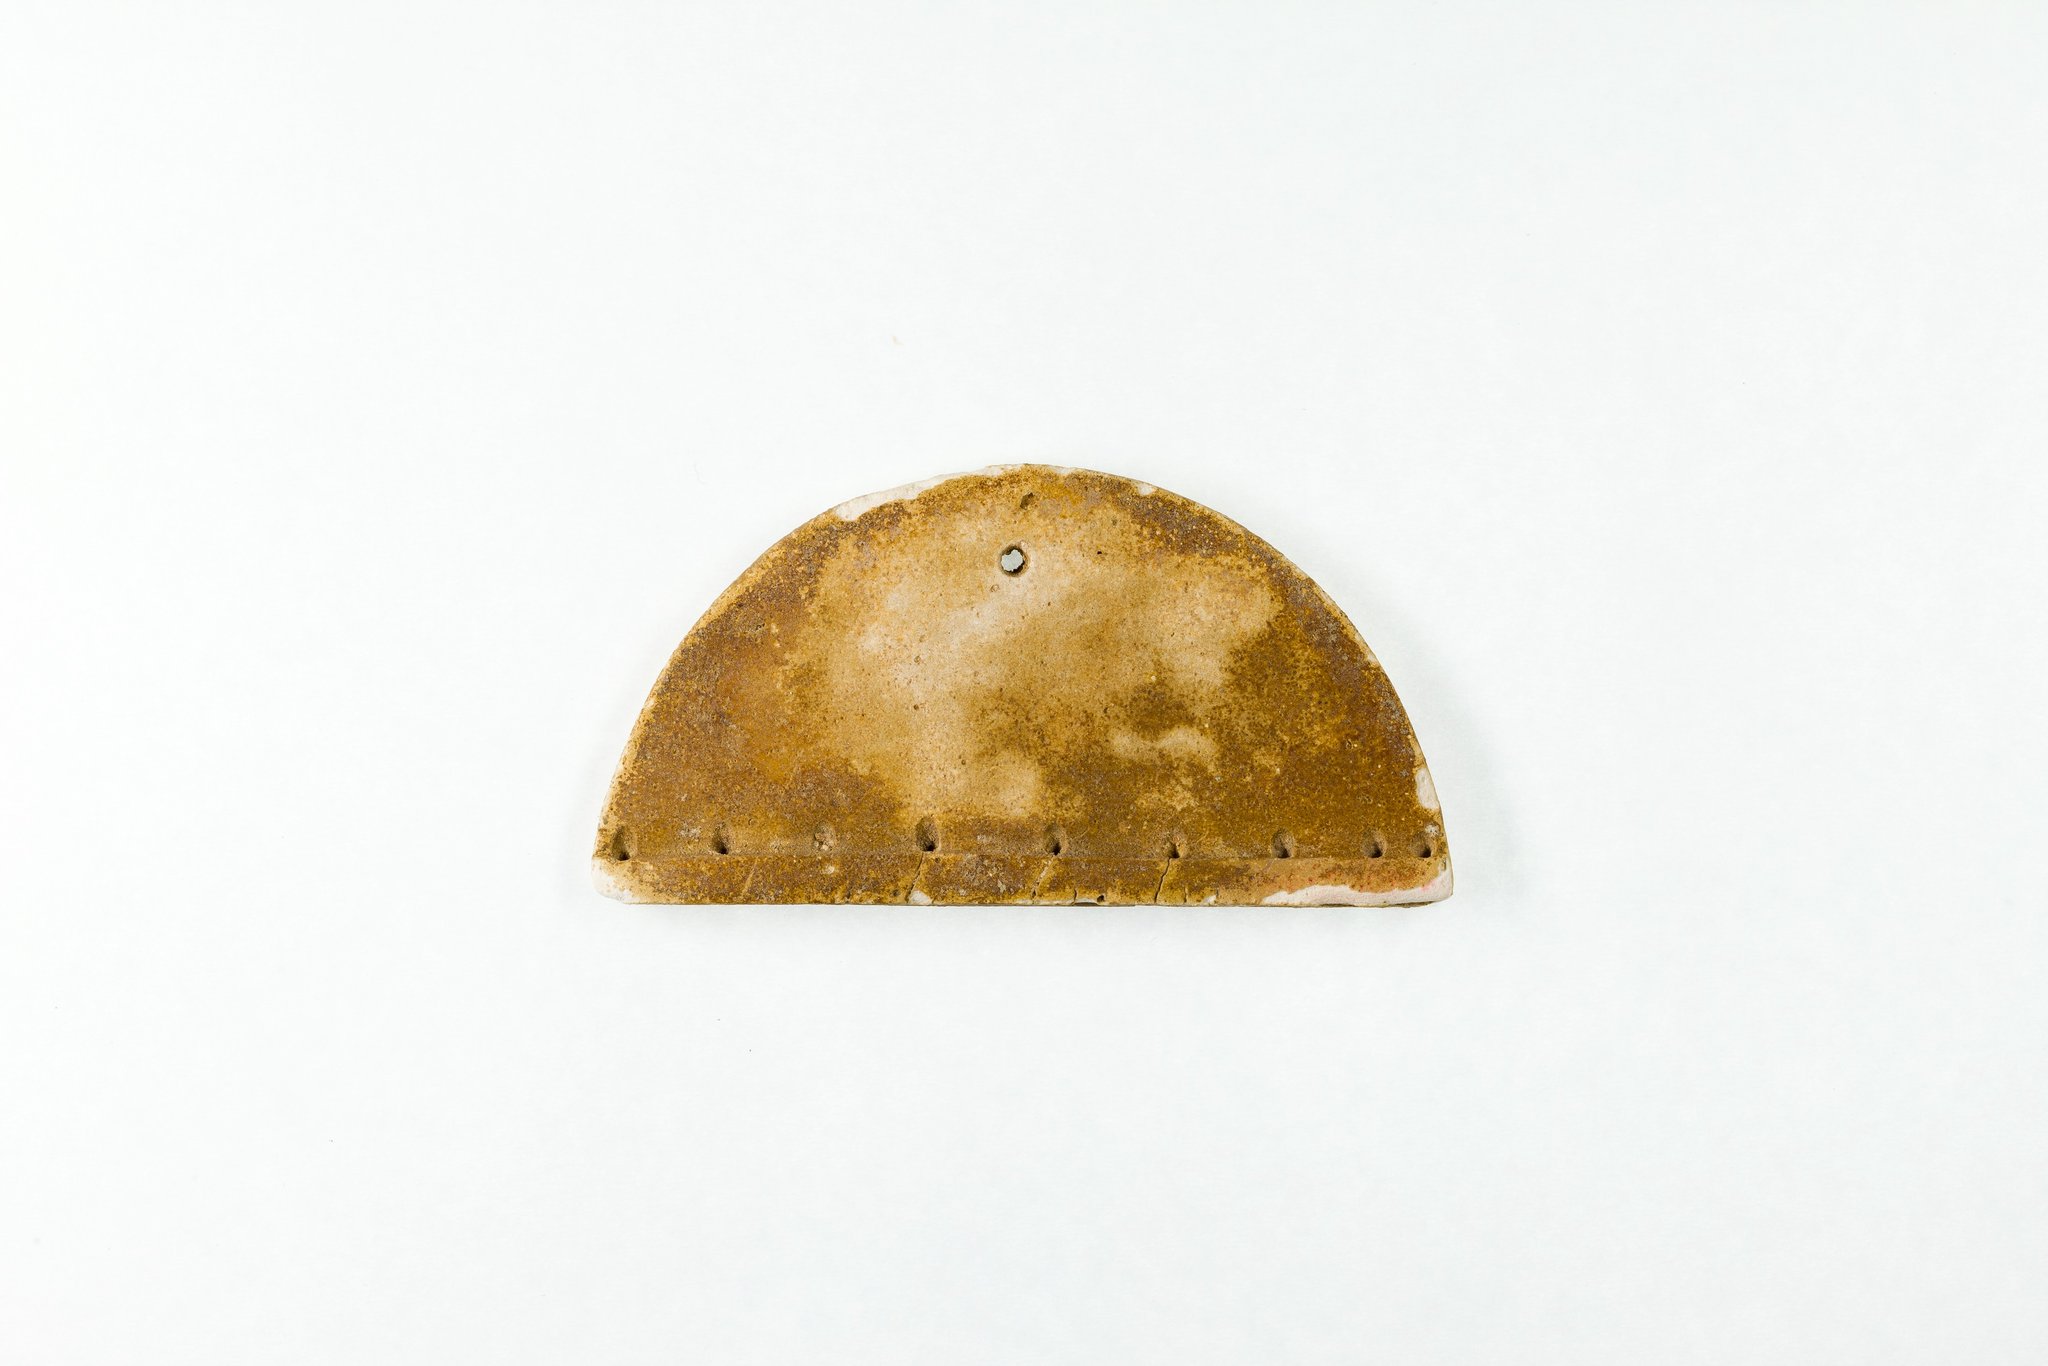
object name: broad collar terminal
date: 1850-1640 BCE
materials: faience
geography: egypt